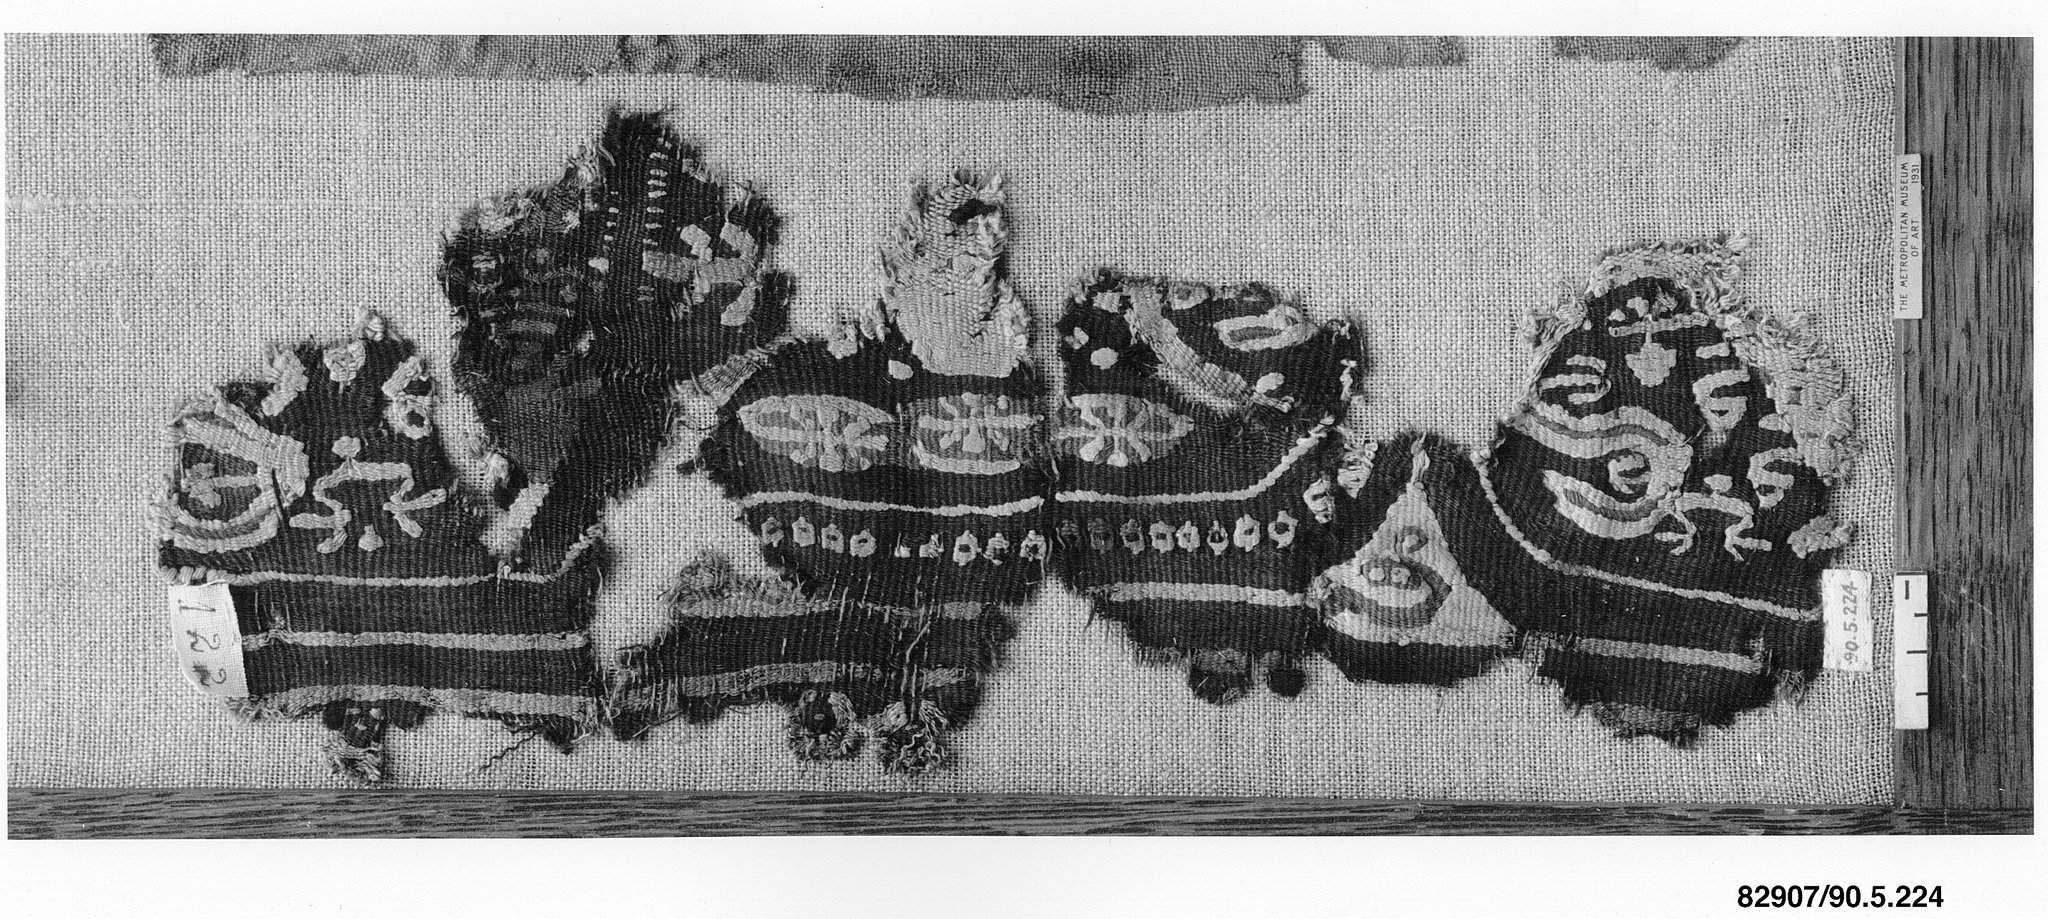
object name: textile fragment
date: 401-600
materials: linen, wool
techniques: weave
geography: egypt